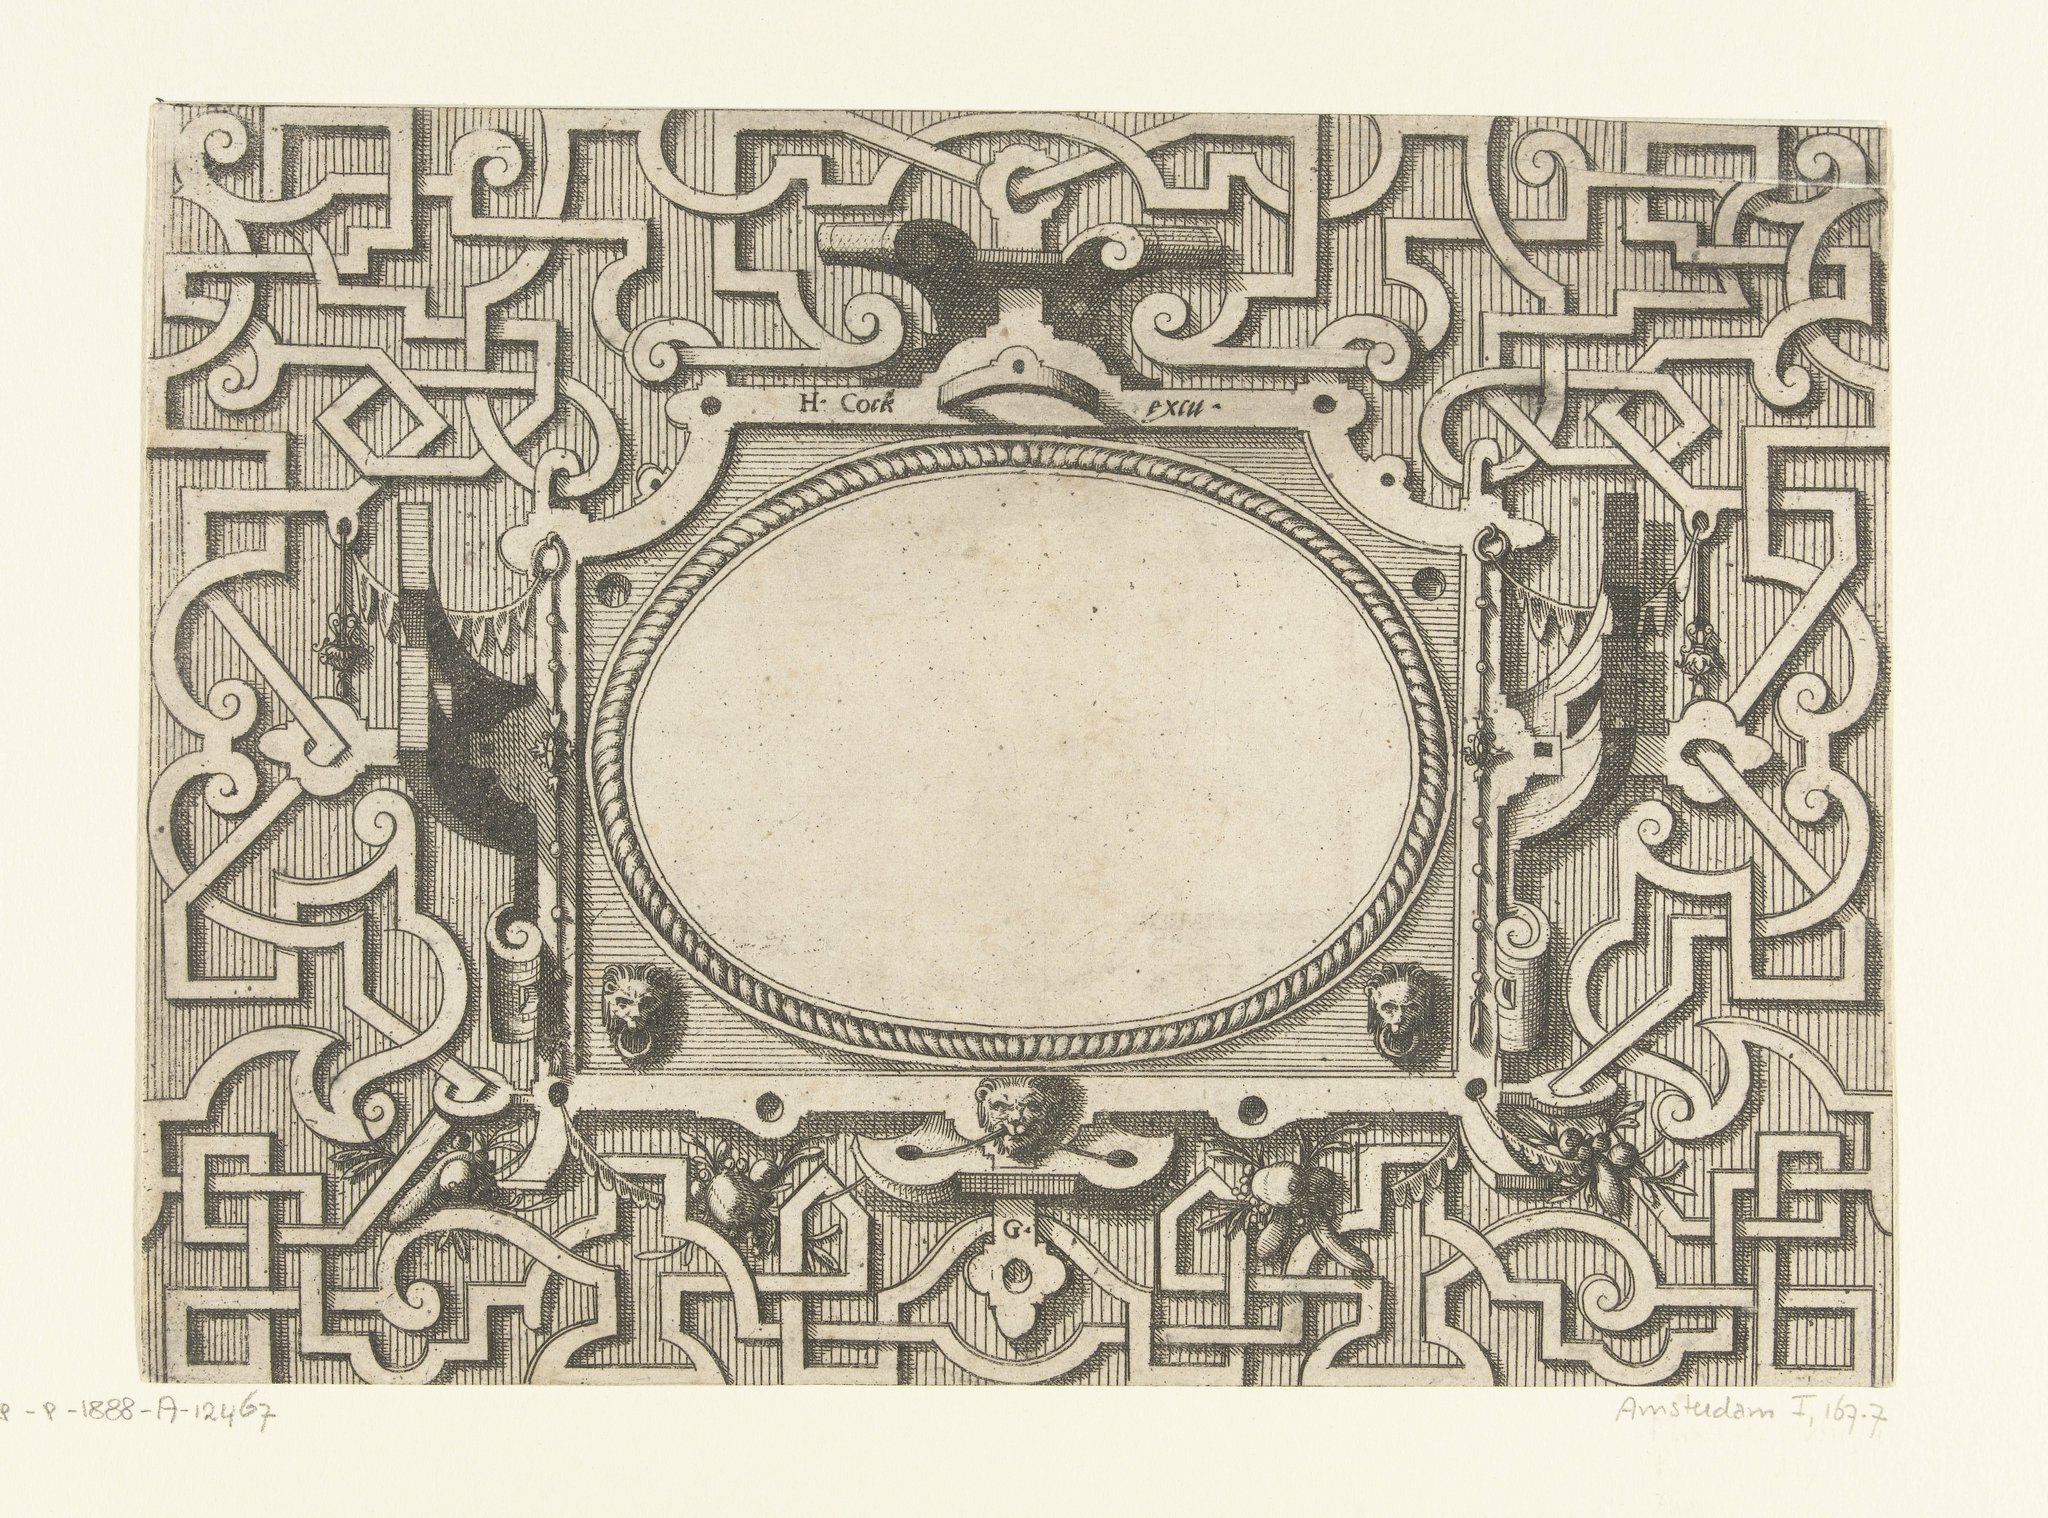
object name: ornament print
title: Ovale cartouche met een koordrand, omgeven door moresken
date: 1555-1560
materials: paper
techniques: etching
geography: netherlands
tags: ornament ~ moresque, ornament ~ cartouche, mask, mascaron ~ ornament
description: Op de onderrand van de cartouche zit een mascaron. Blad G uit serie van 16 bladen, geletterd A-Q. Gearceerde of gestippelde achtergrond.